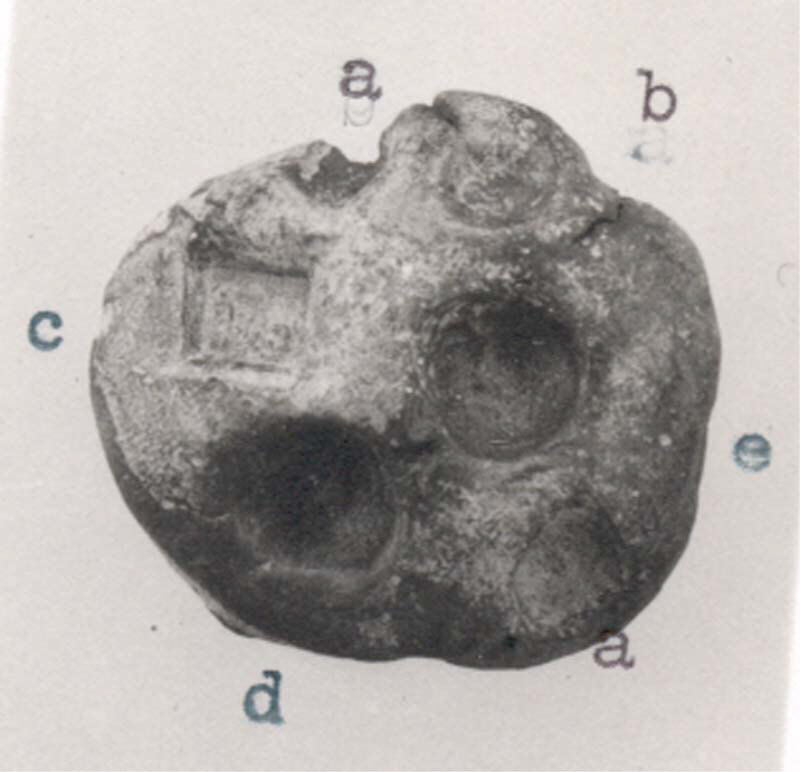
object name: sealing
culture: sasanian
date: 601-700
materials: clay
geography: iran